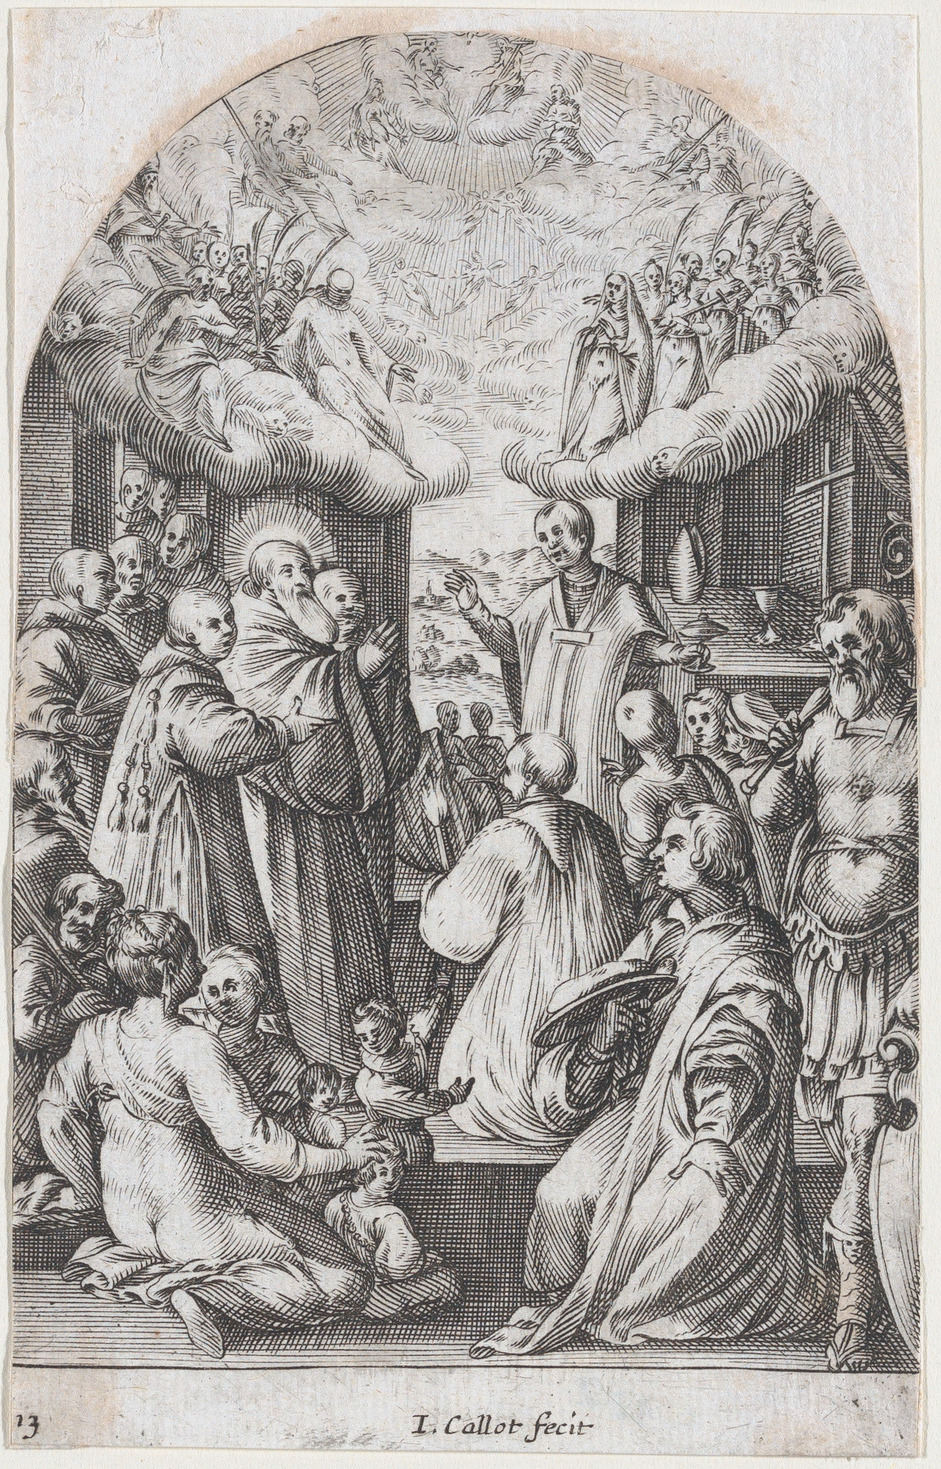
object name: print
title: The Death of St. Benedict, plate 13 from "Les Eglises Jubilaires" (The Paintings of Rome, The Churches Jubilee)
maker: jacques callot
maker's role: artist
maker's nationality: french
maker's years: 1592-1635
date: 1607-1611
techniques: engraving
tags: children,men,women,saints